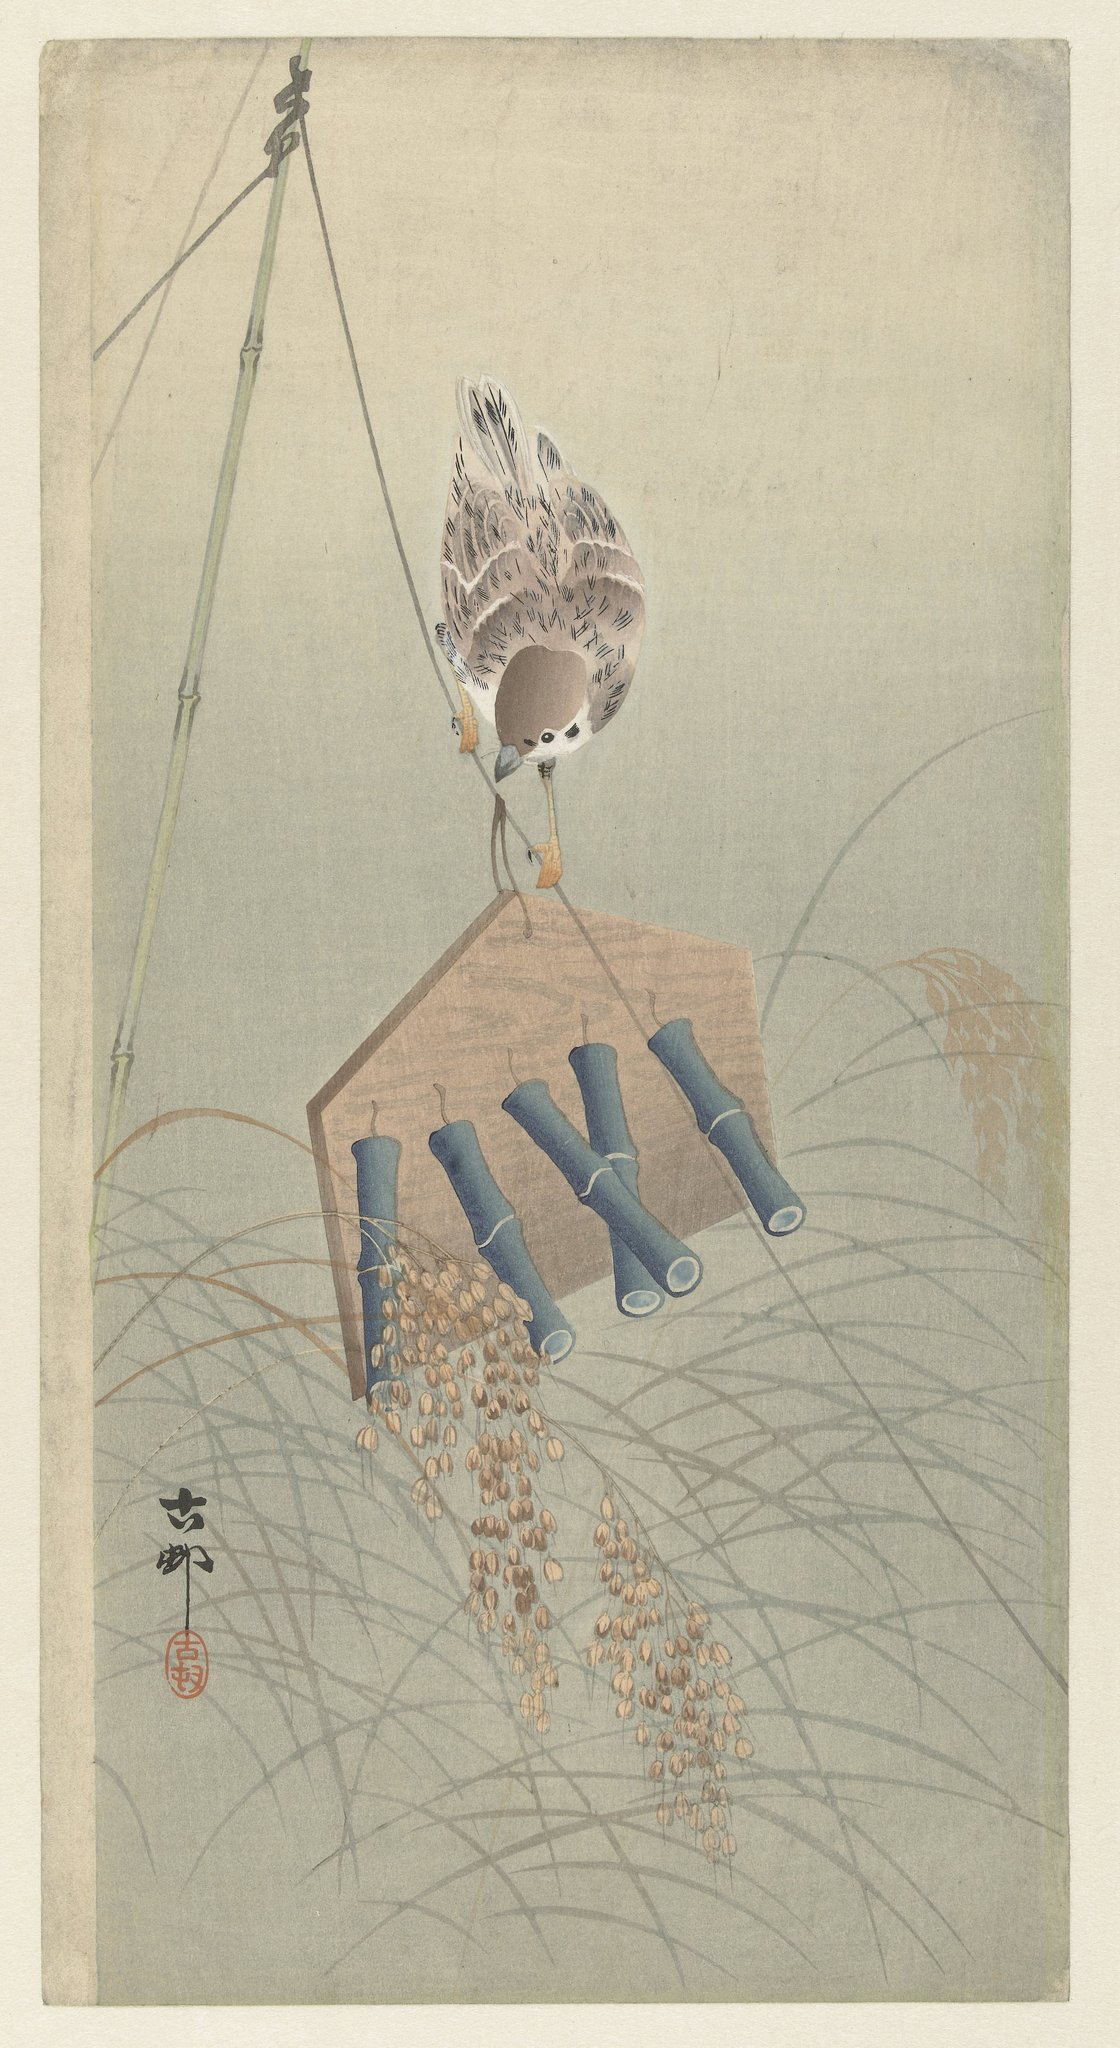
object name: print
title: Portret van Friedrich Gedike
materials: paper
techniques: stippling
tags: berlin, historical persons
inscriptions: collector's mark: Lugt 2228, collector's mark: Lugt 2760